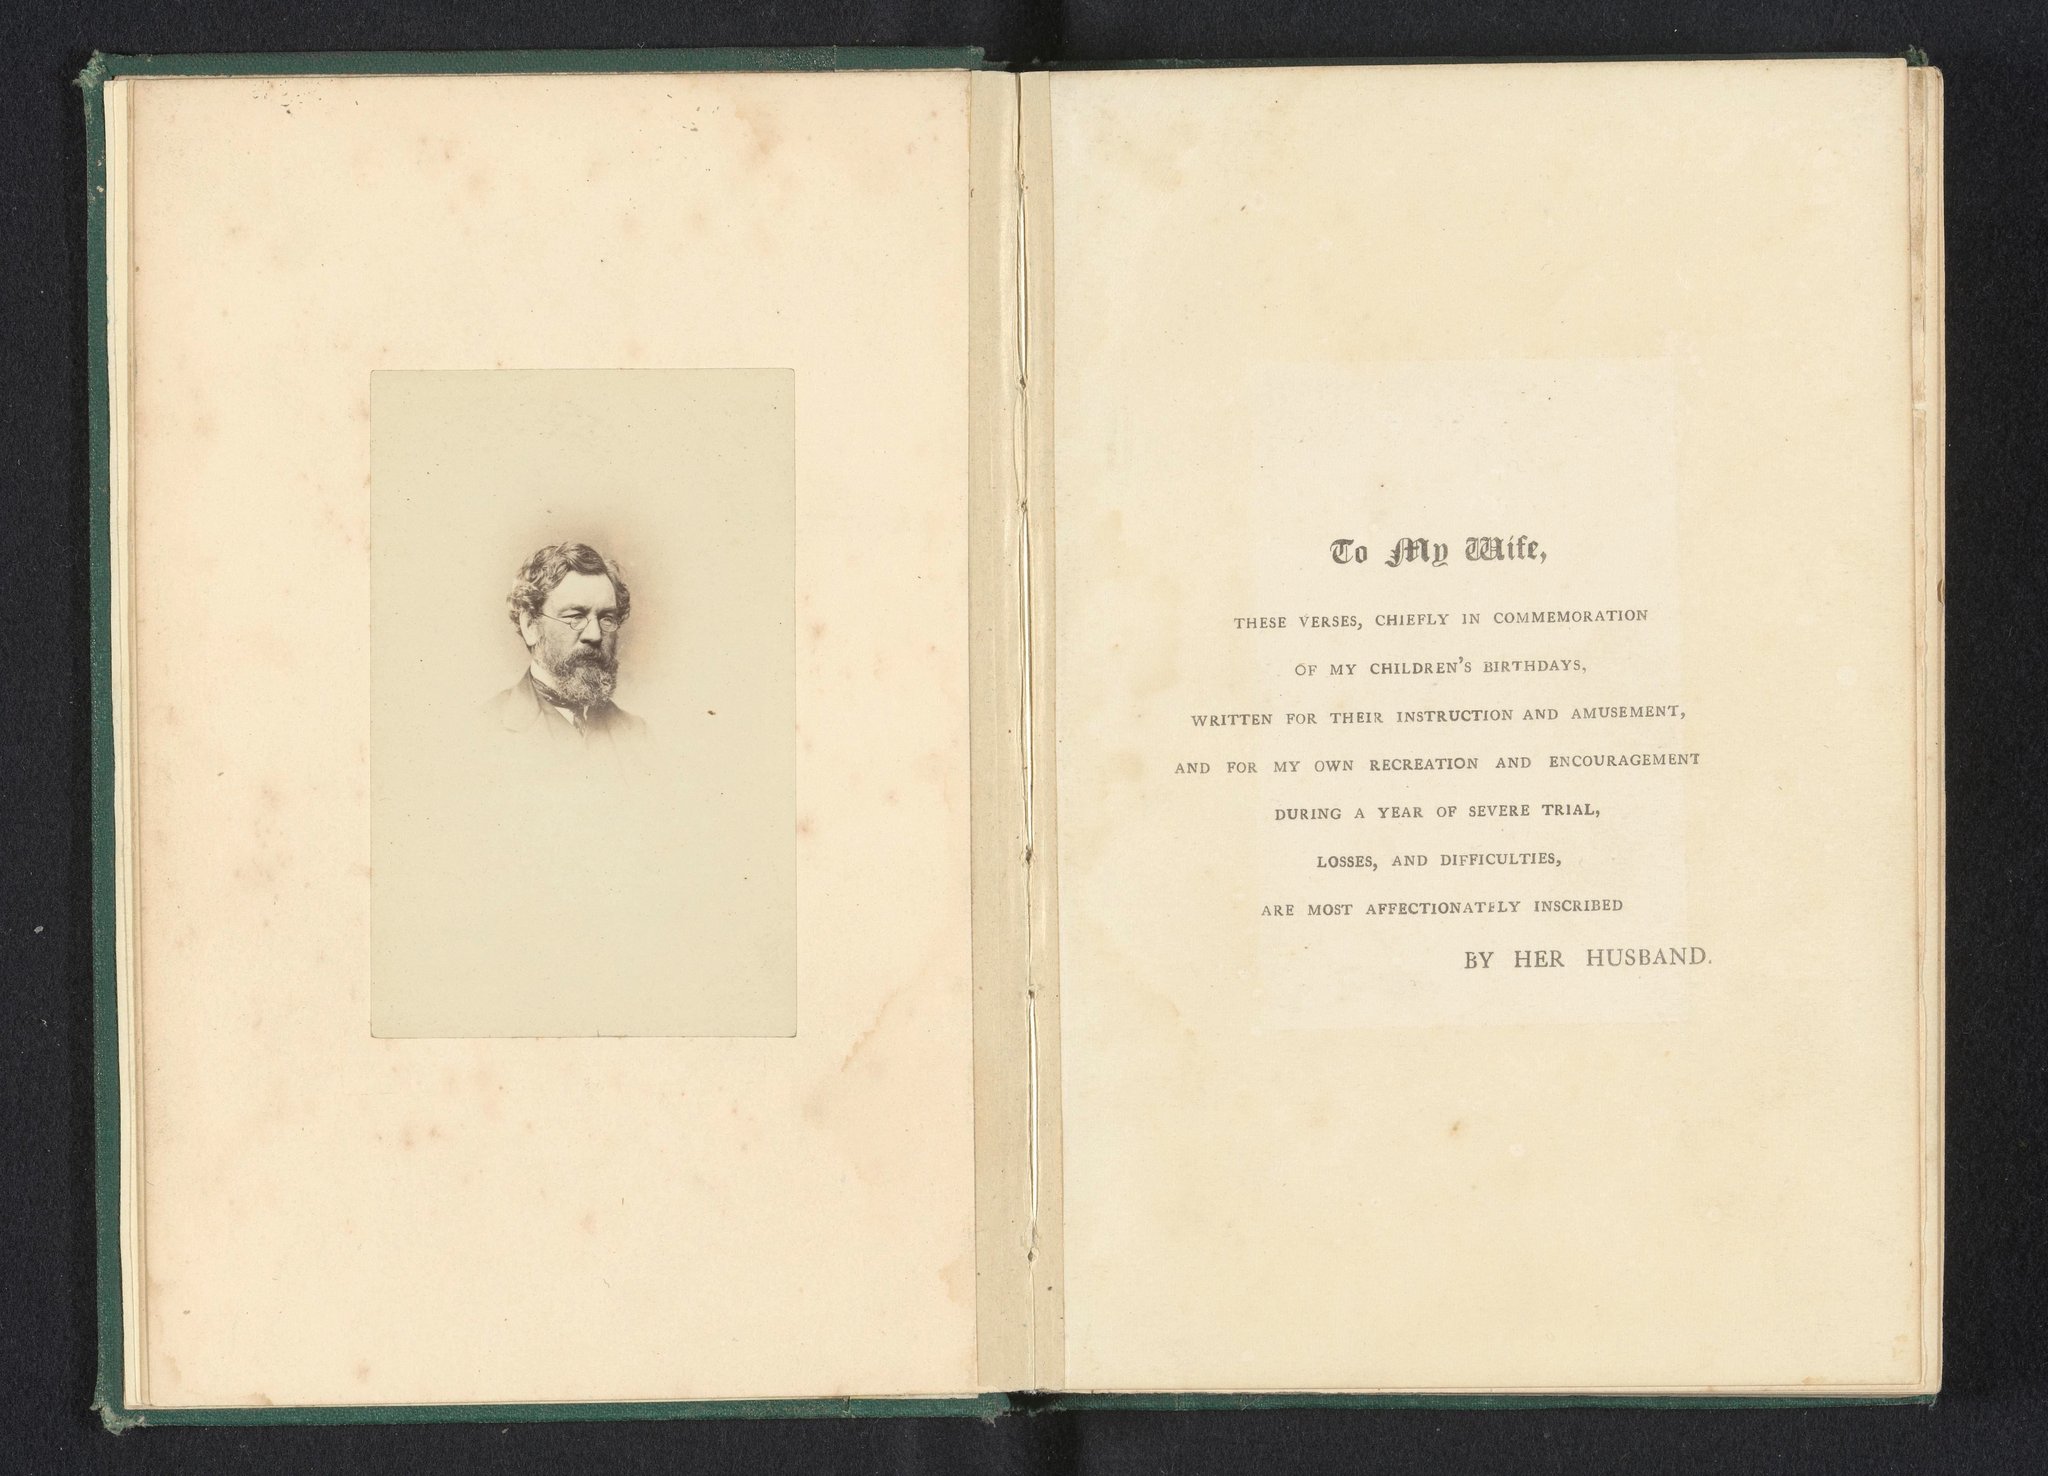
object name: photograph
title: Portret van Father John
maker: Anonymous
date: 1863-1868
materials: photographic support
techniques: albumen print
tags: functionaries and dignitaries ~ protestant churches